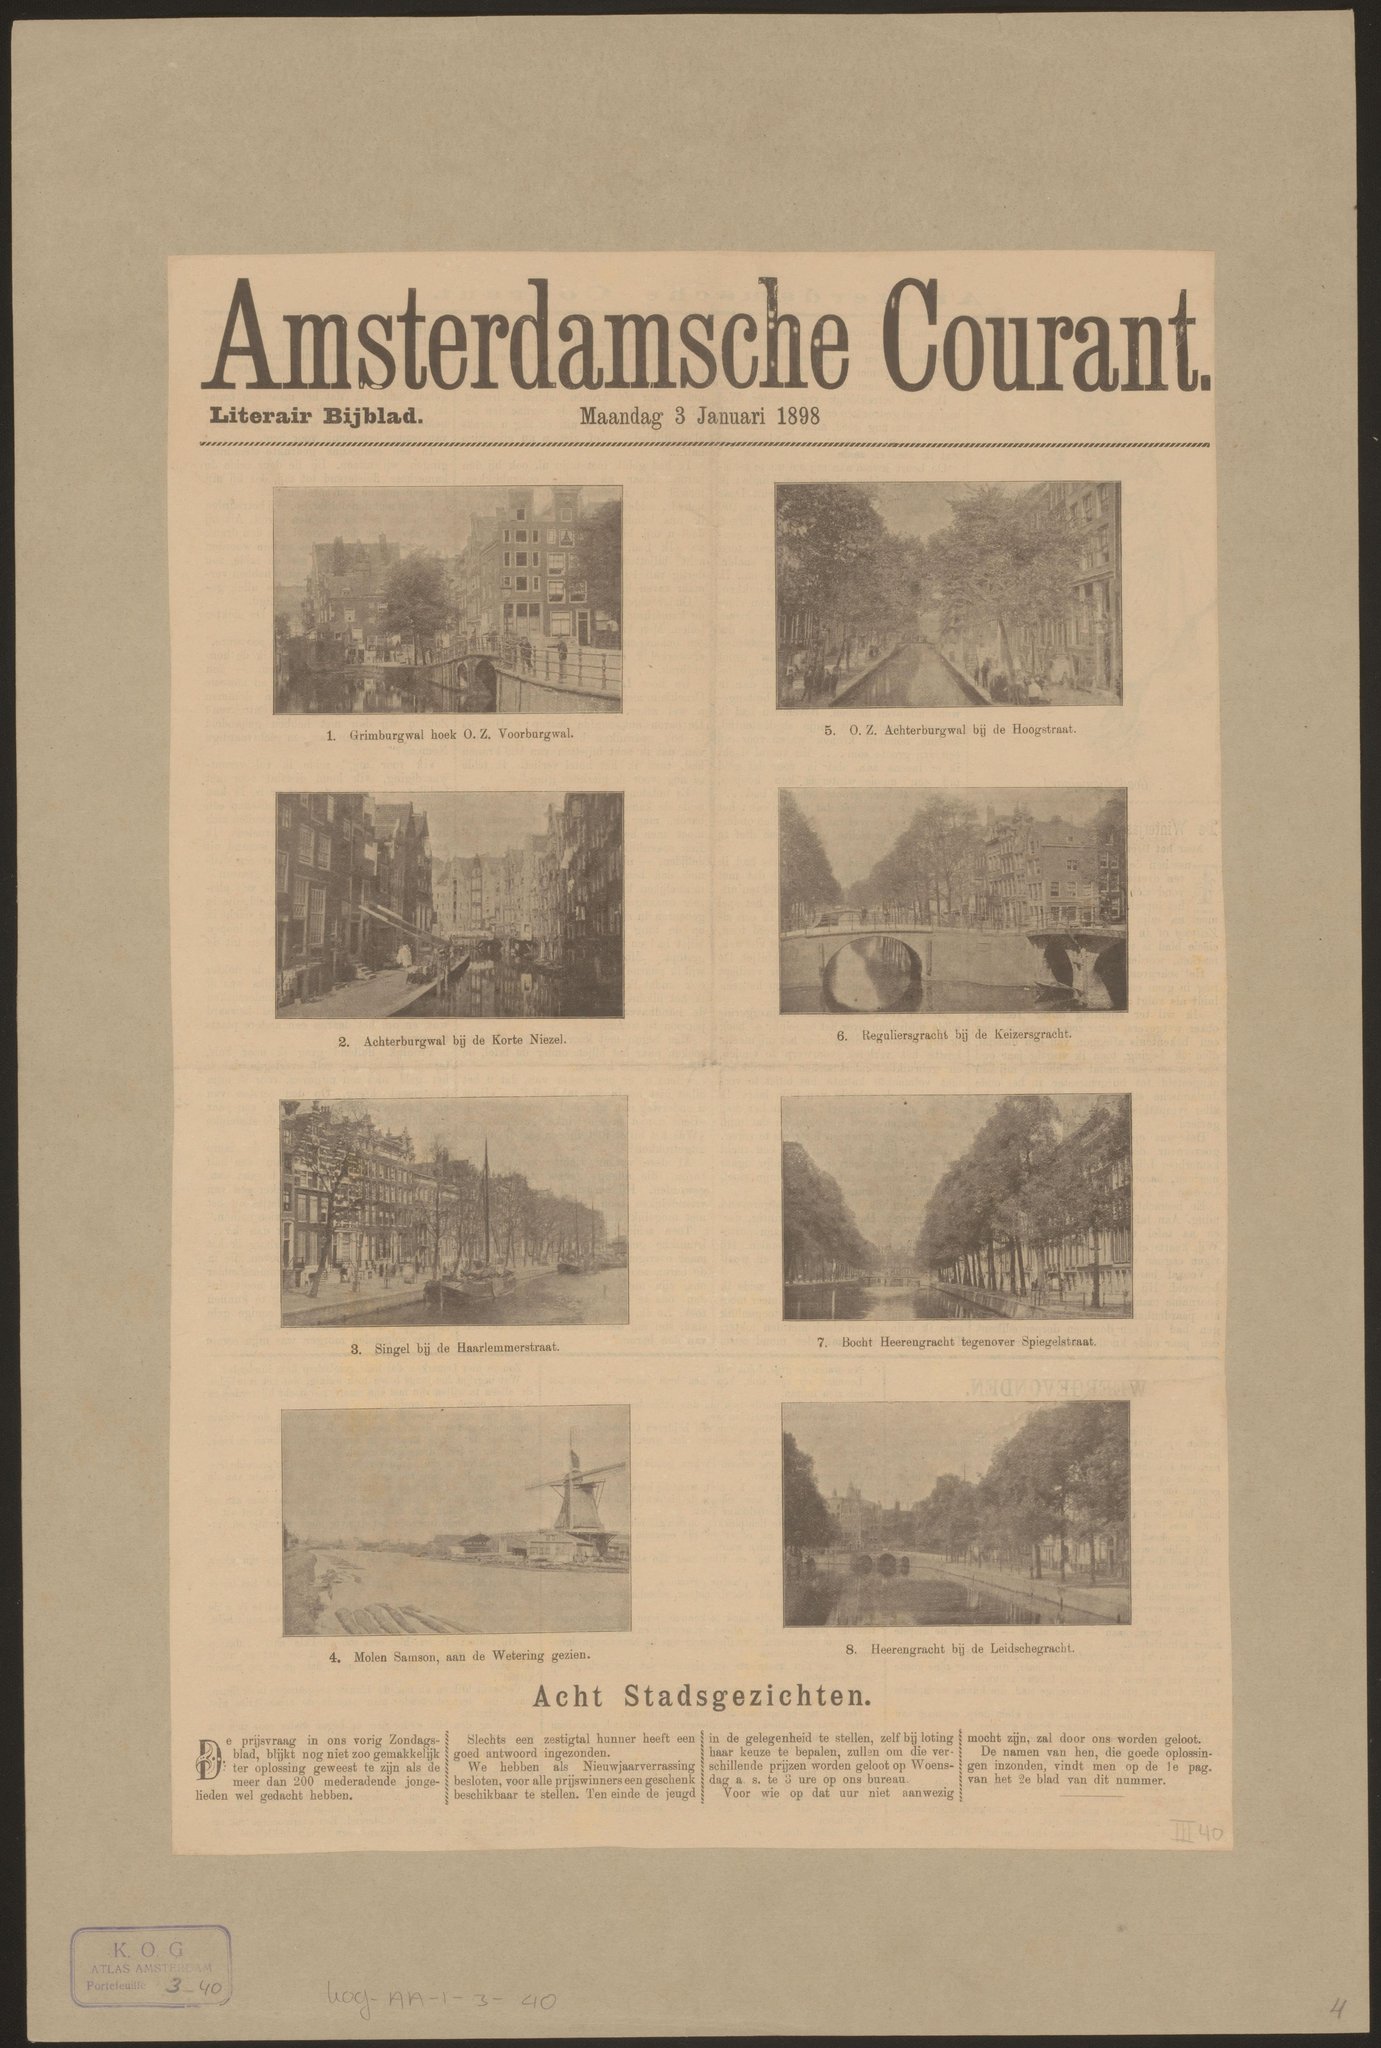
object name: page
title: Acht gezichten op Amsterdam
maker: Anonymous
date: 1898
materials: paper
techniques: letterpress printing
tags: city-view in general; 'veduta', canal, windmill in landscape, the usual house or row of houses, bridge in city across river, canal, etc., amsterdam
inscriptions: collector's mark: ‘3-40’ Lugt 1641b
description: Onderwerpsrubriek binnen de Atlas Amsterdam: Panorama's en verzamelprenten. Gezichten op de Grimburgwal, Oudezijds Achterburgwal, Achterburgwal, Reguliersgracht, Singel bij de Haarlemmerstraat, Herengracht tegenover de Spiegelstraat, Molen De Samson en de Herengracht bij de Leidsegracht.